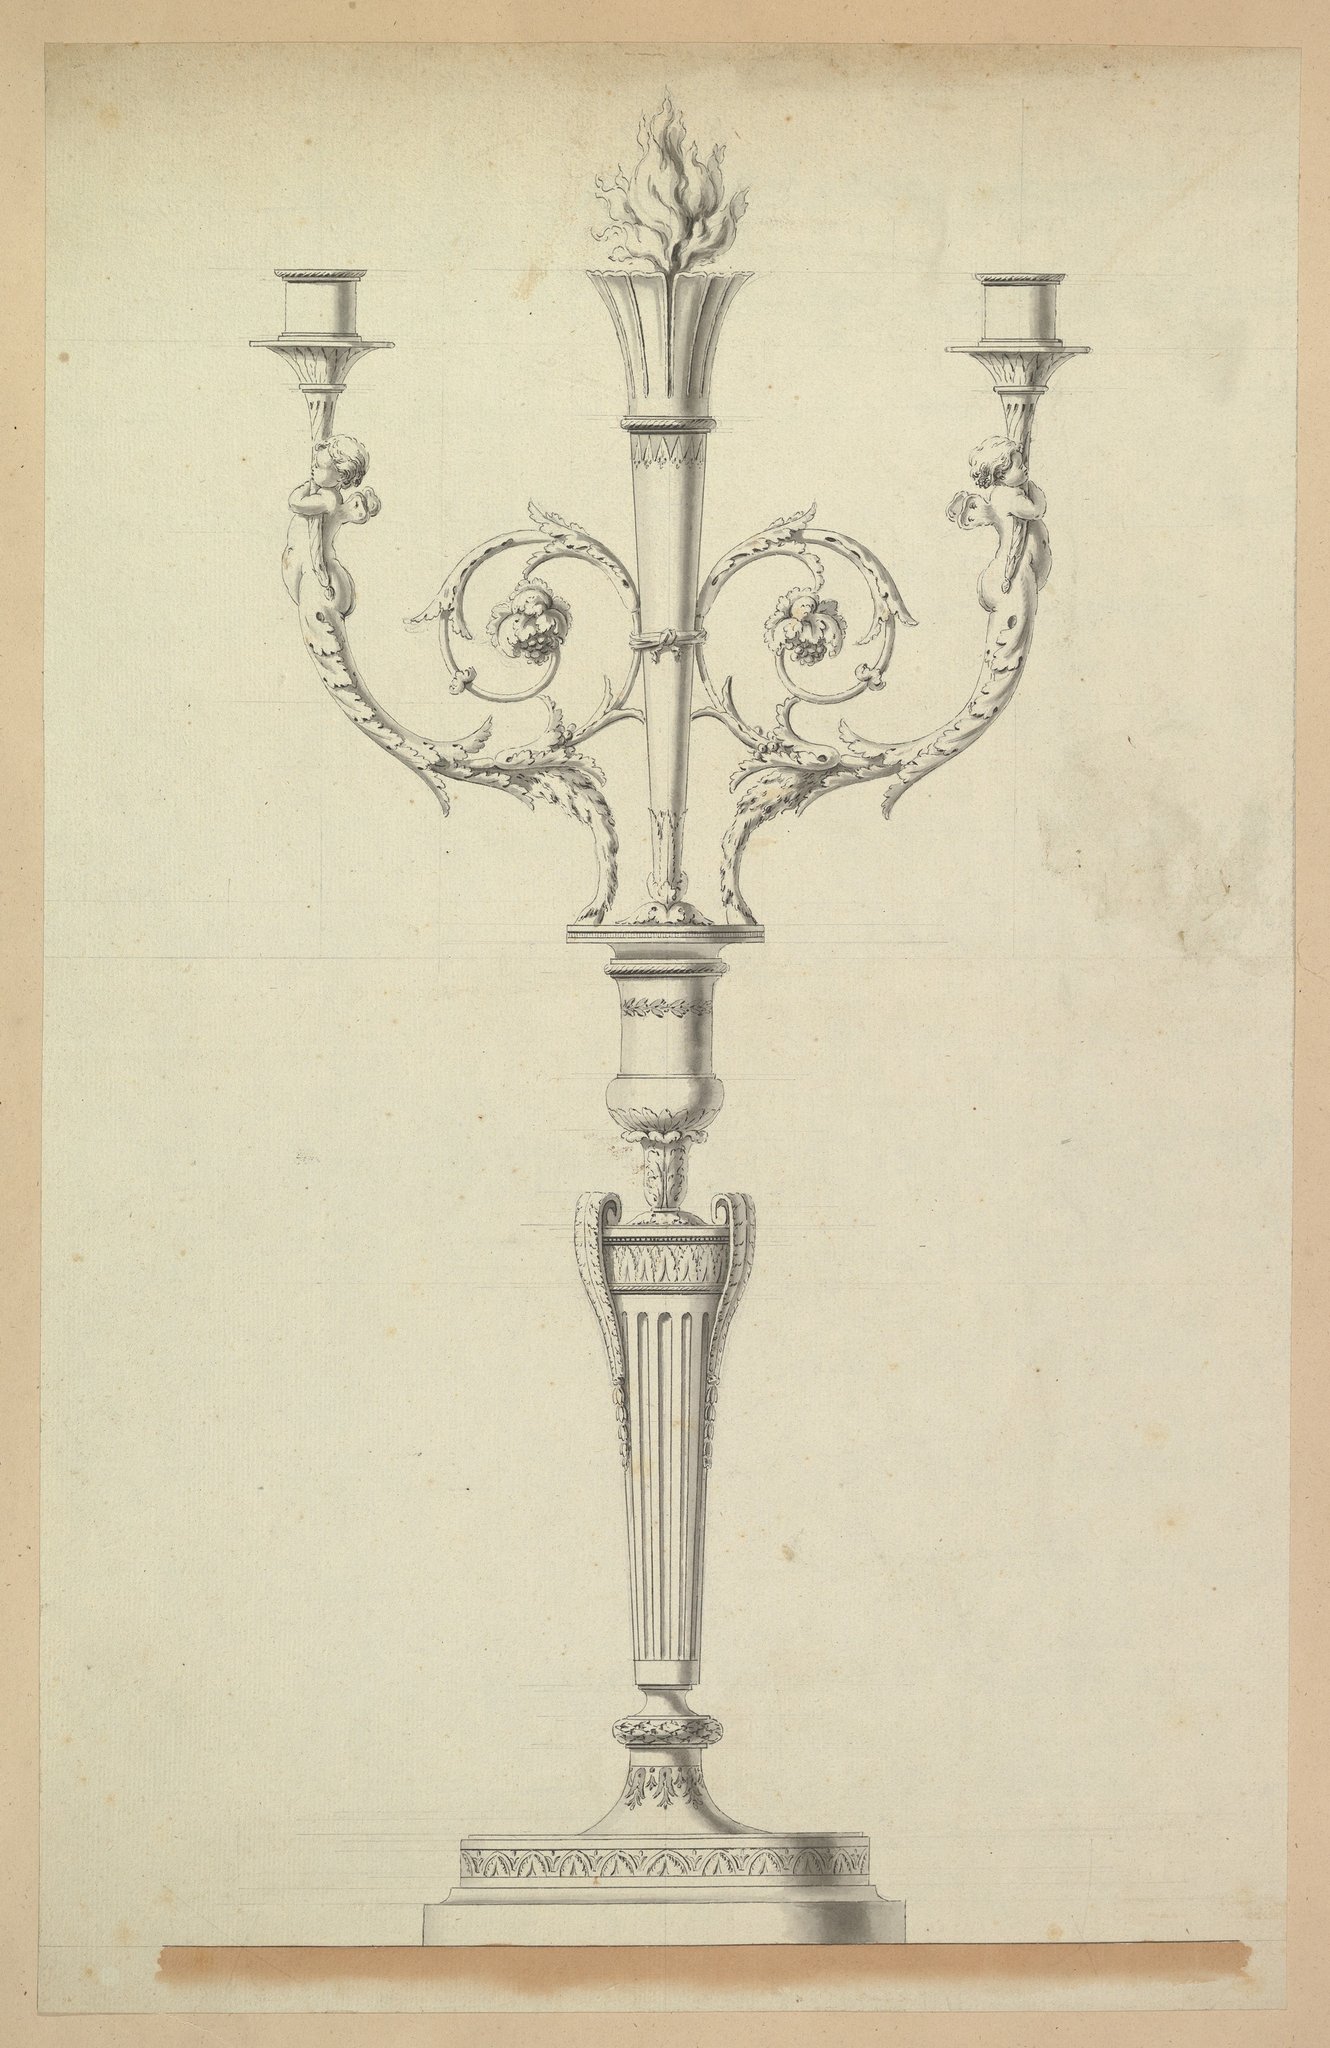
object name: drawing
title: Design for a Chandelier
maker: anonymous, french, 18th century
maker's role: artist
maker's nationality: french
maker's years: 1700-1800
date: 1701-1800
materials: graphite, ink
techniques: brush, pen, wash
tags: chandelier